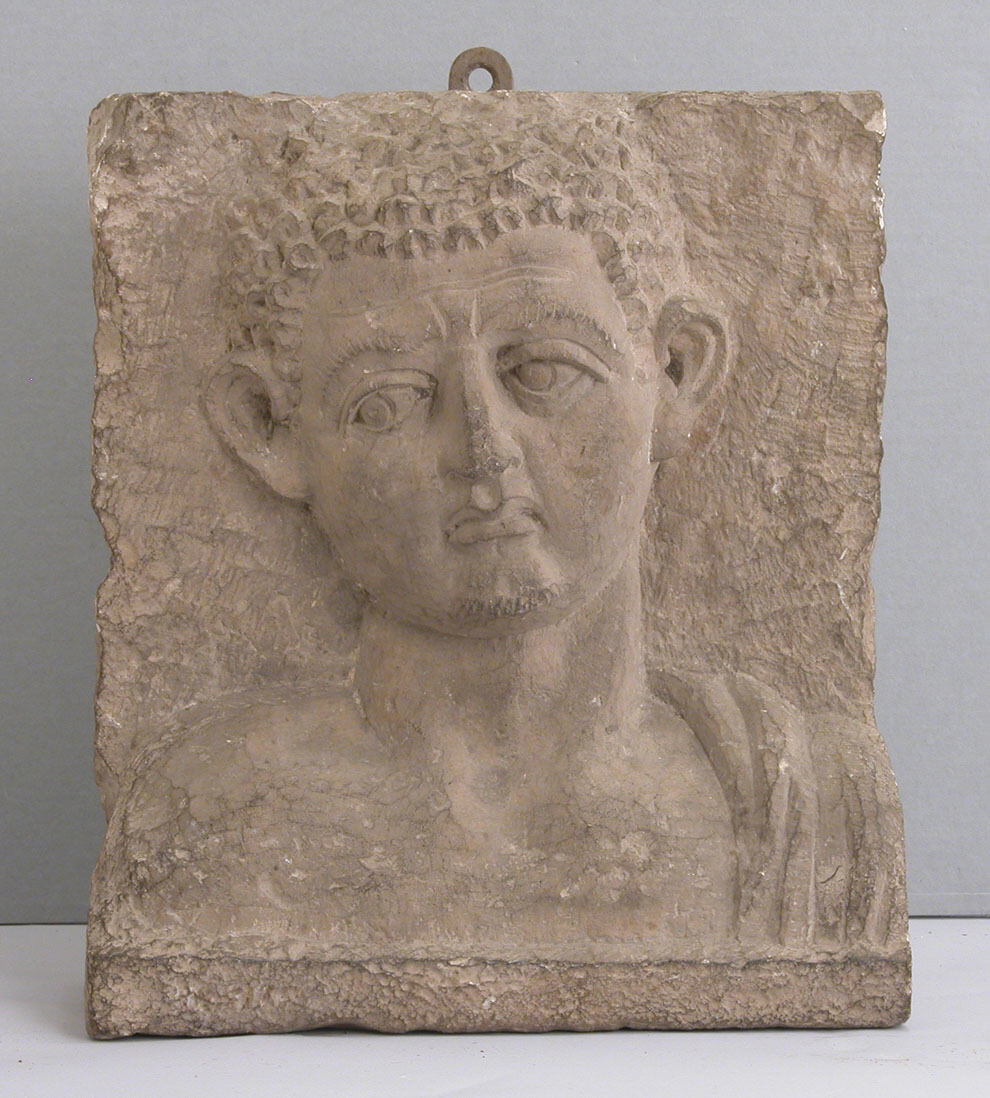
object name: relief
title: Relief with the Bust of a Young Man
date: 301-400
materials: stone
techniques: carving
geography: egypt or syria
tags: men,portraits